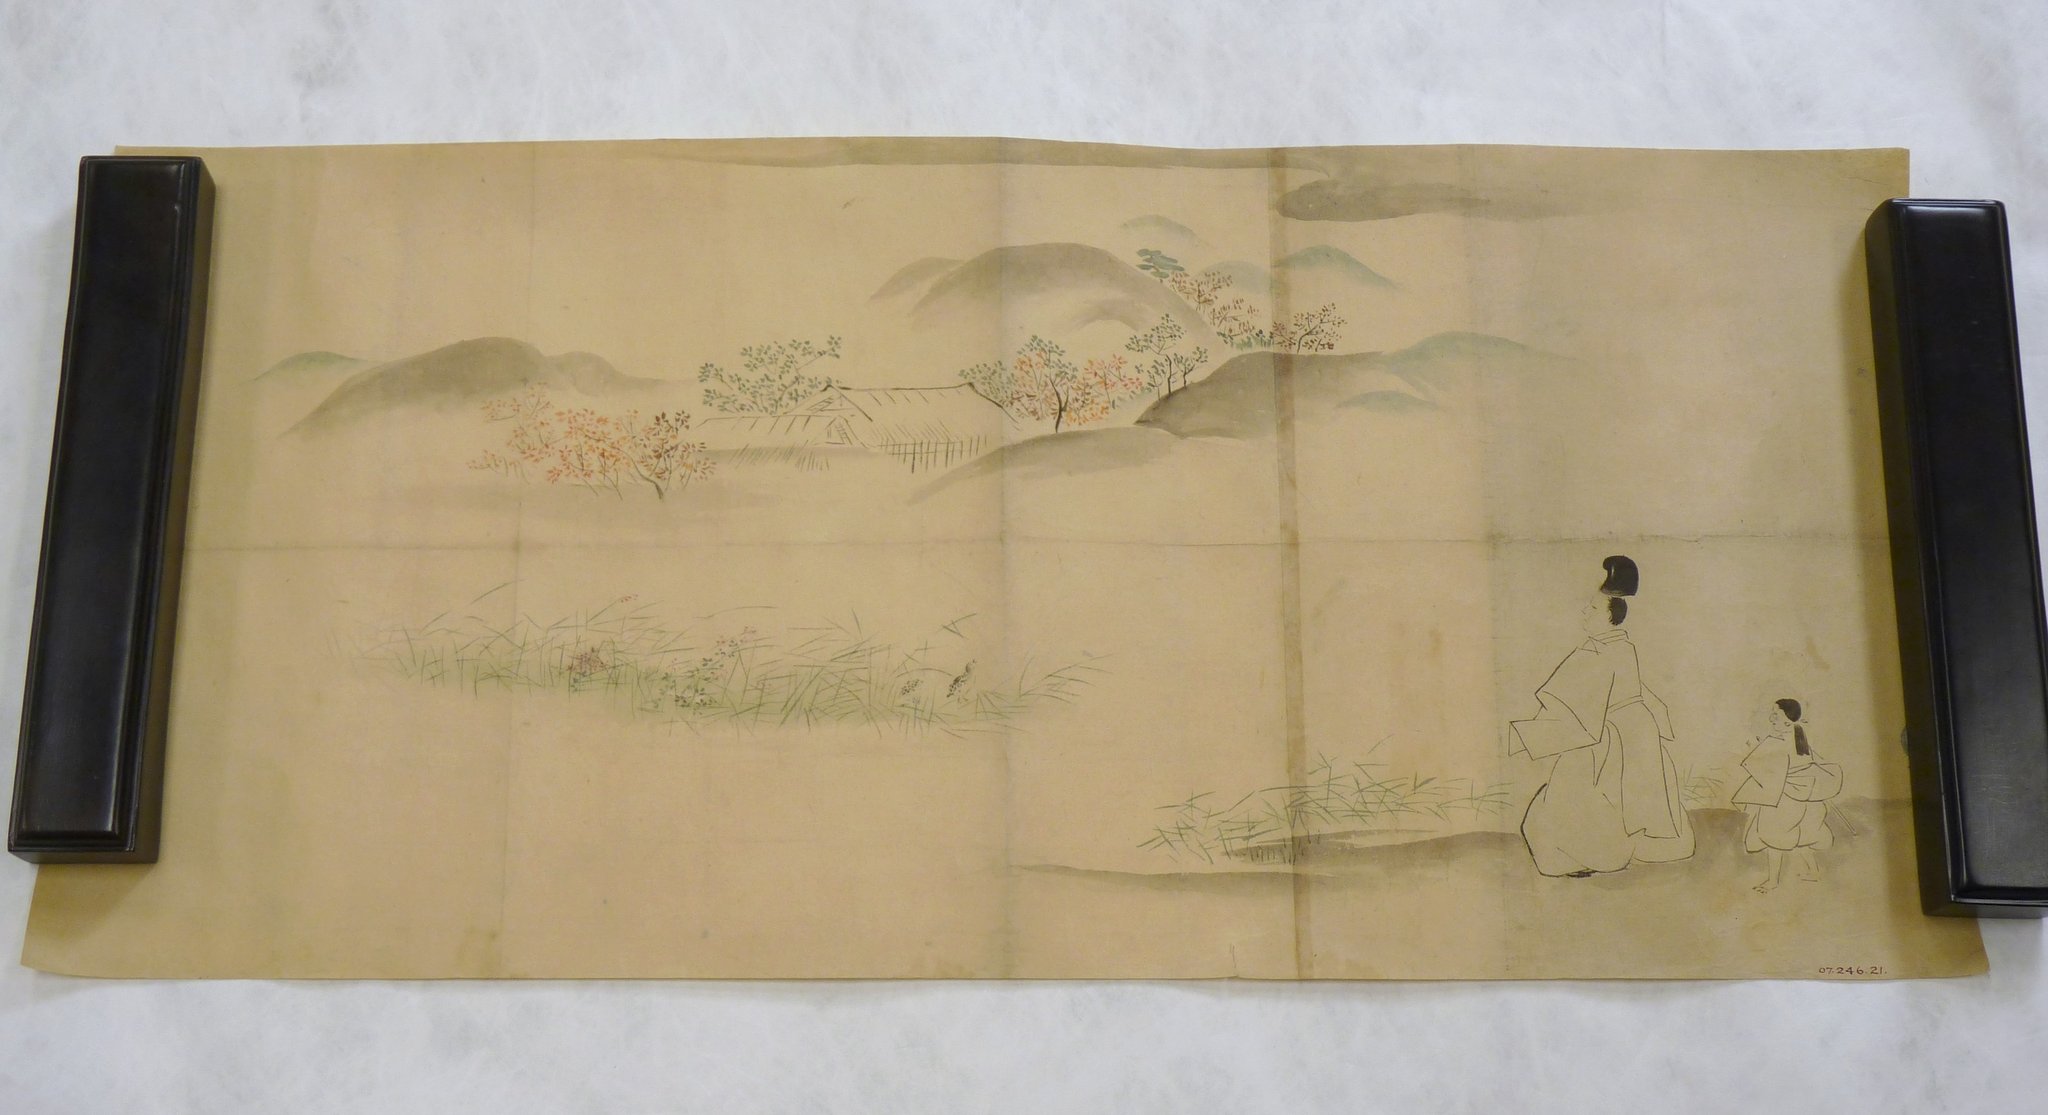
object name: drawing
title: Japanese Drawing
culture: japanese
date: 1801-1833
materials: paper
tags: human figures,trees